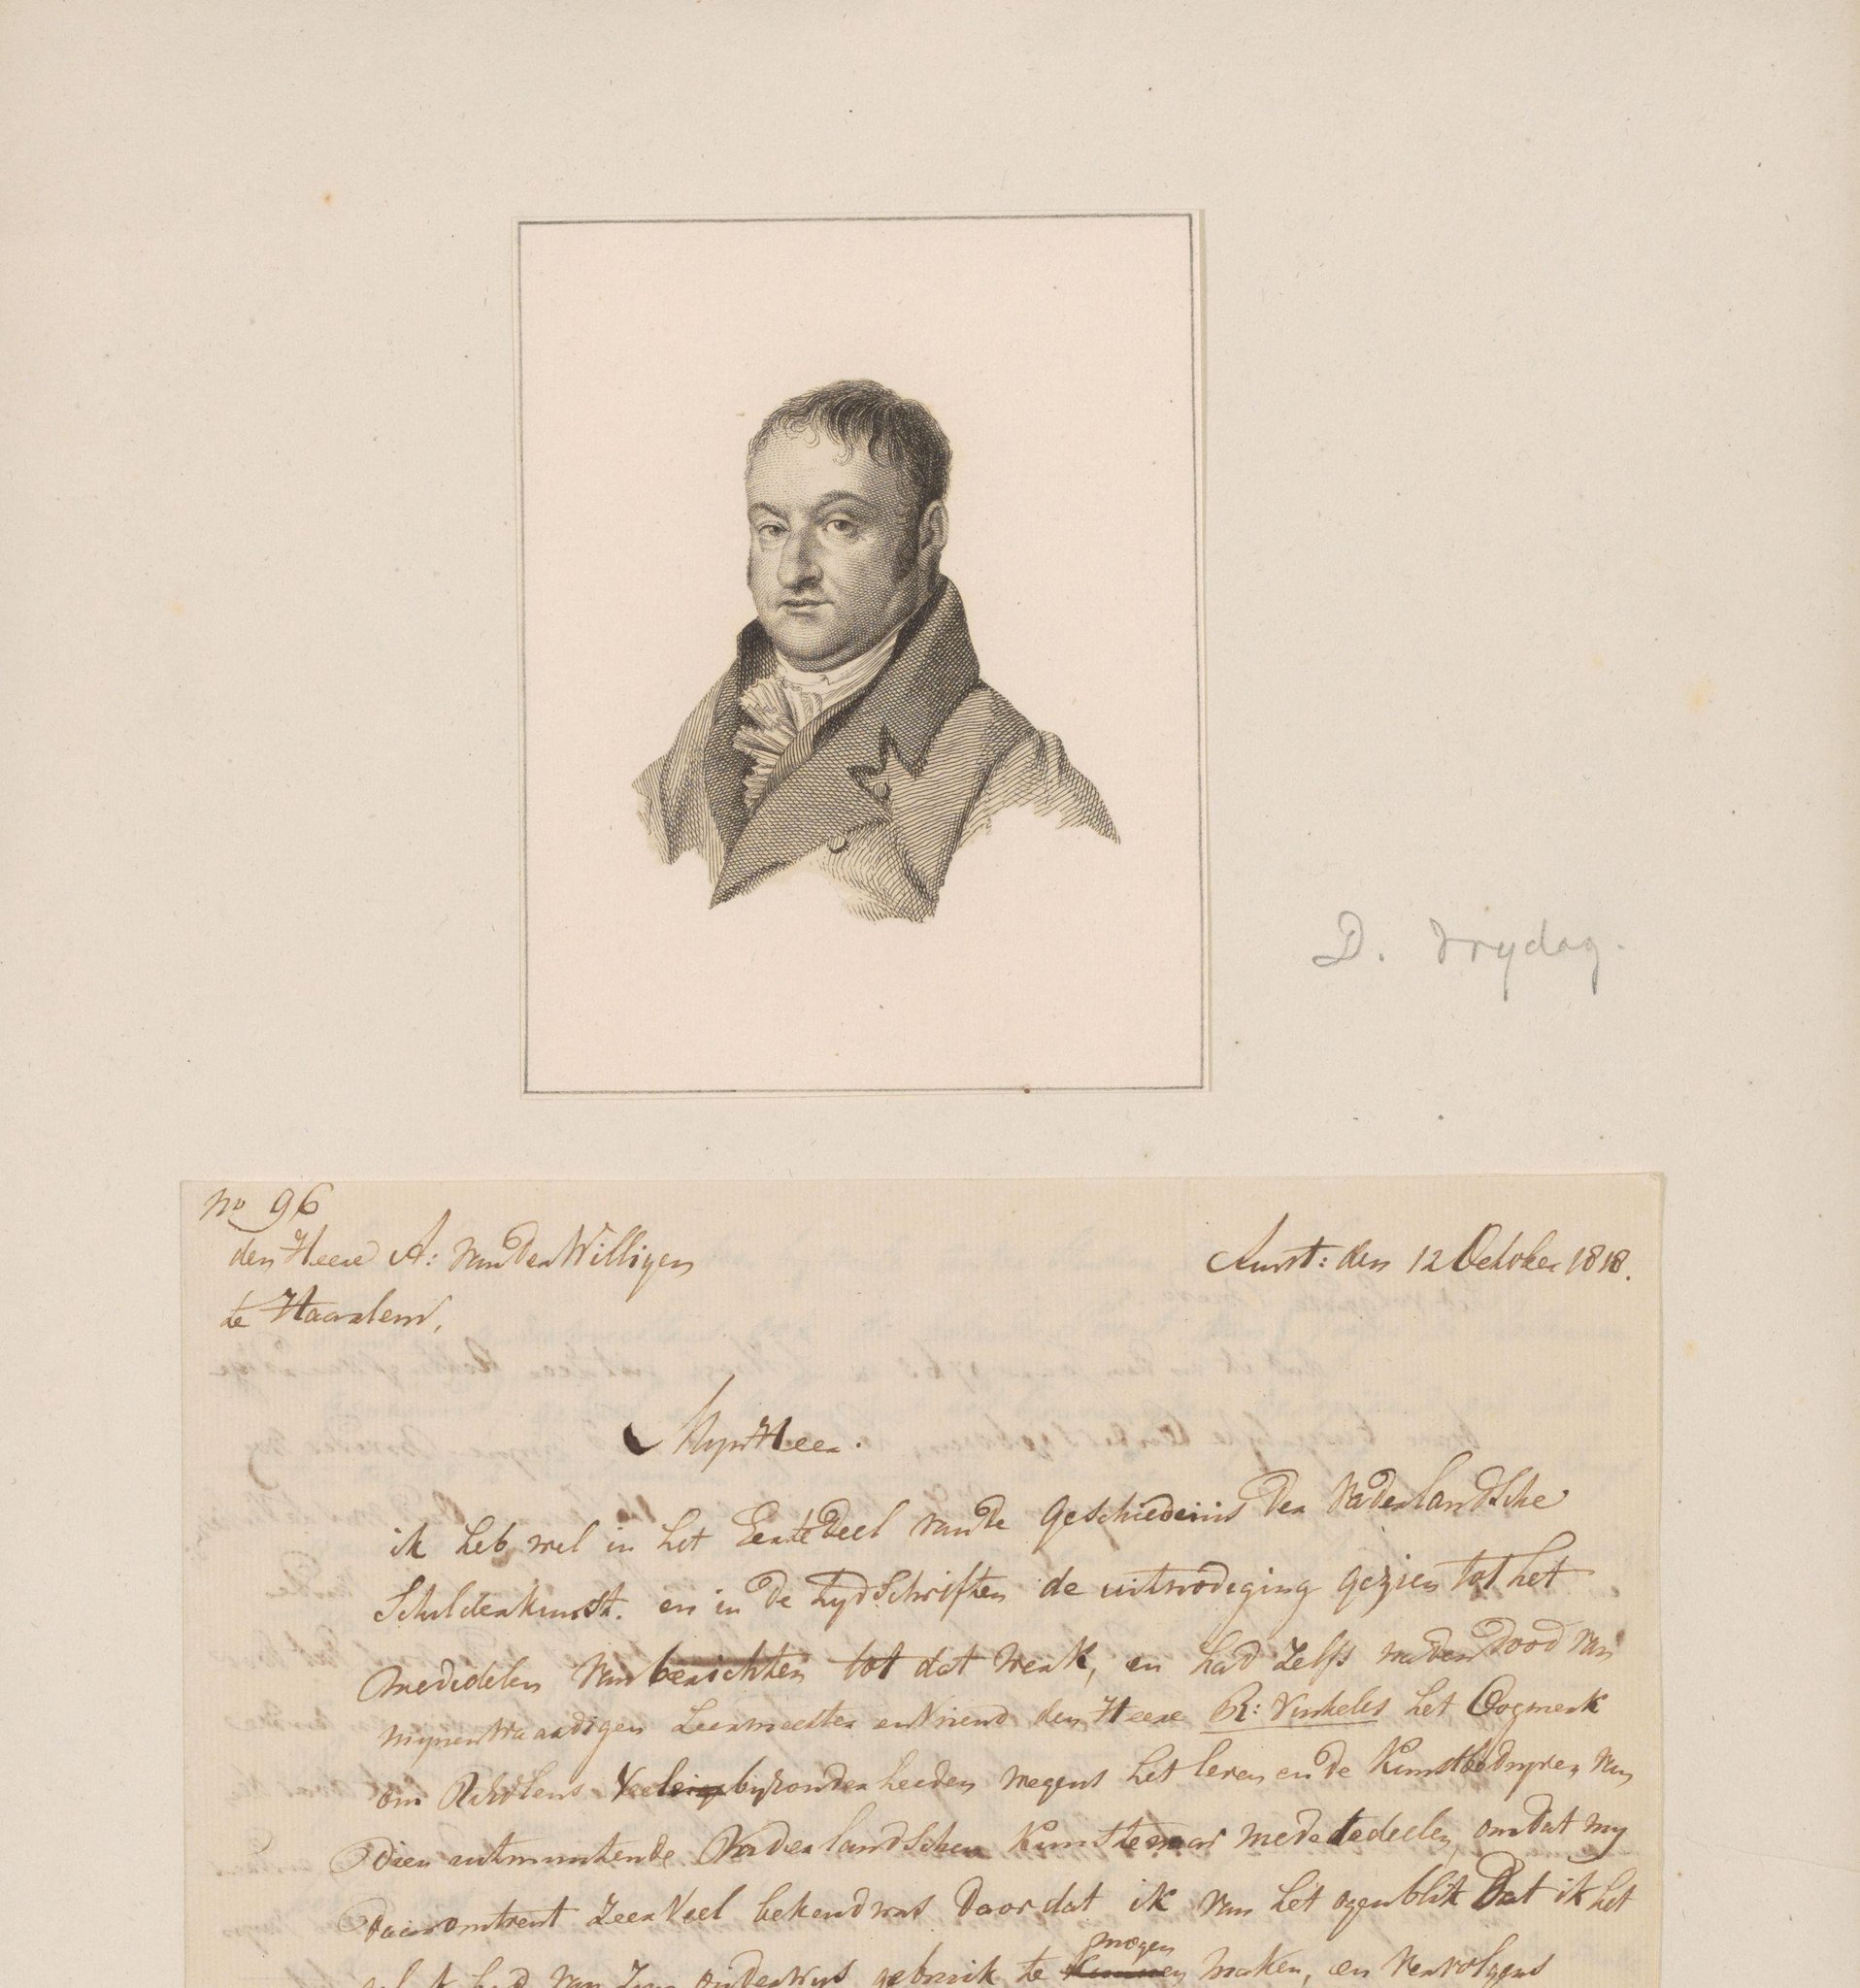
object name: letter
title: Brief aan Adriaan van der Willigen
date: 1818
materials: ink, paper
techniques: etching, pen, writing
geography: amsterdam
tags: rotterdam, haarlem, adriaan van der willigen, amsterdam, print maker, draughtsman, reinier vinkeles (i), distribution of awards ~ art contest, the graphic arts, historical persons (portraits and scenes from the life)